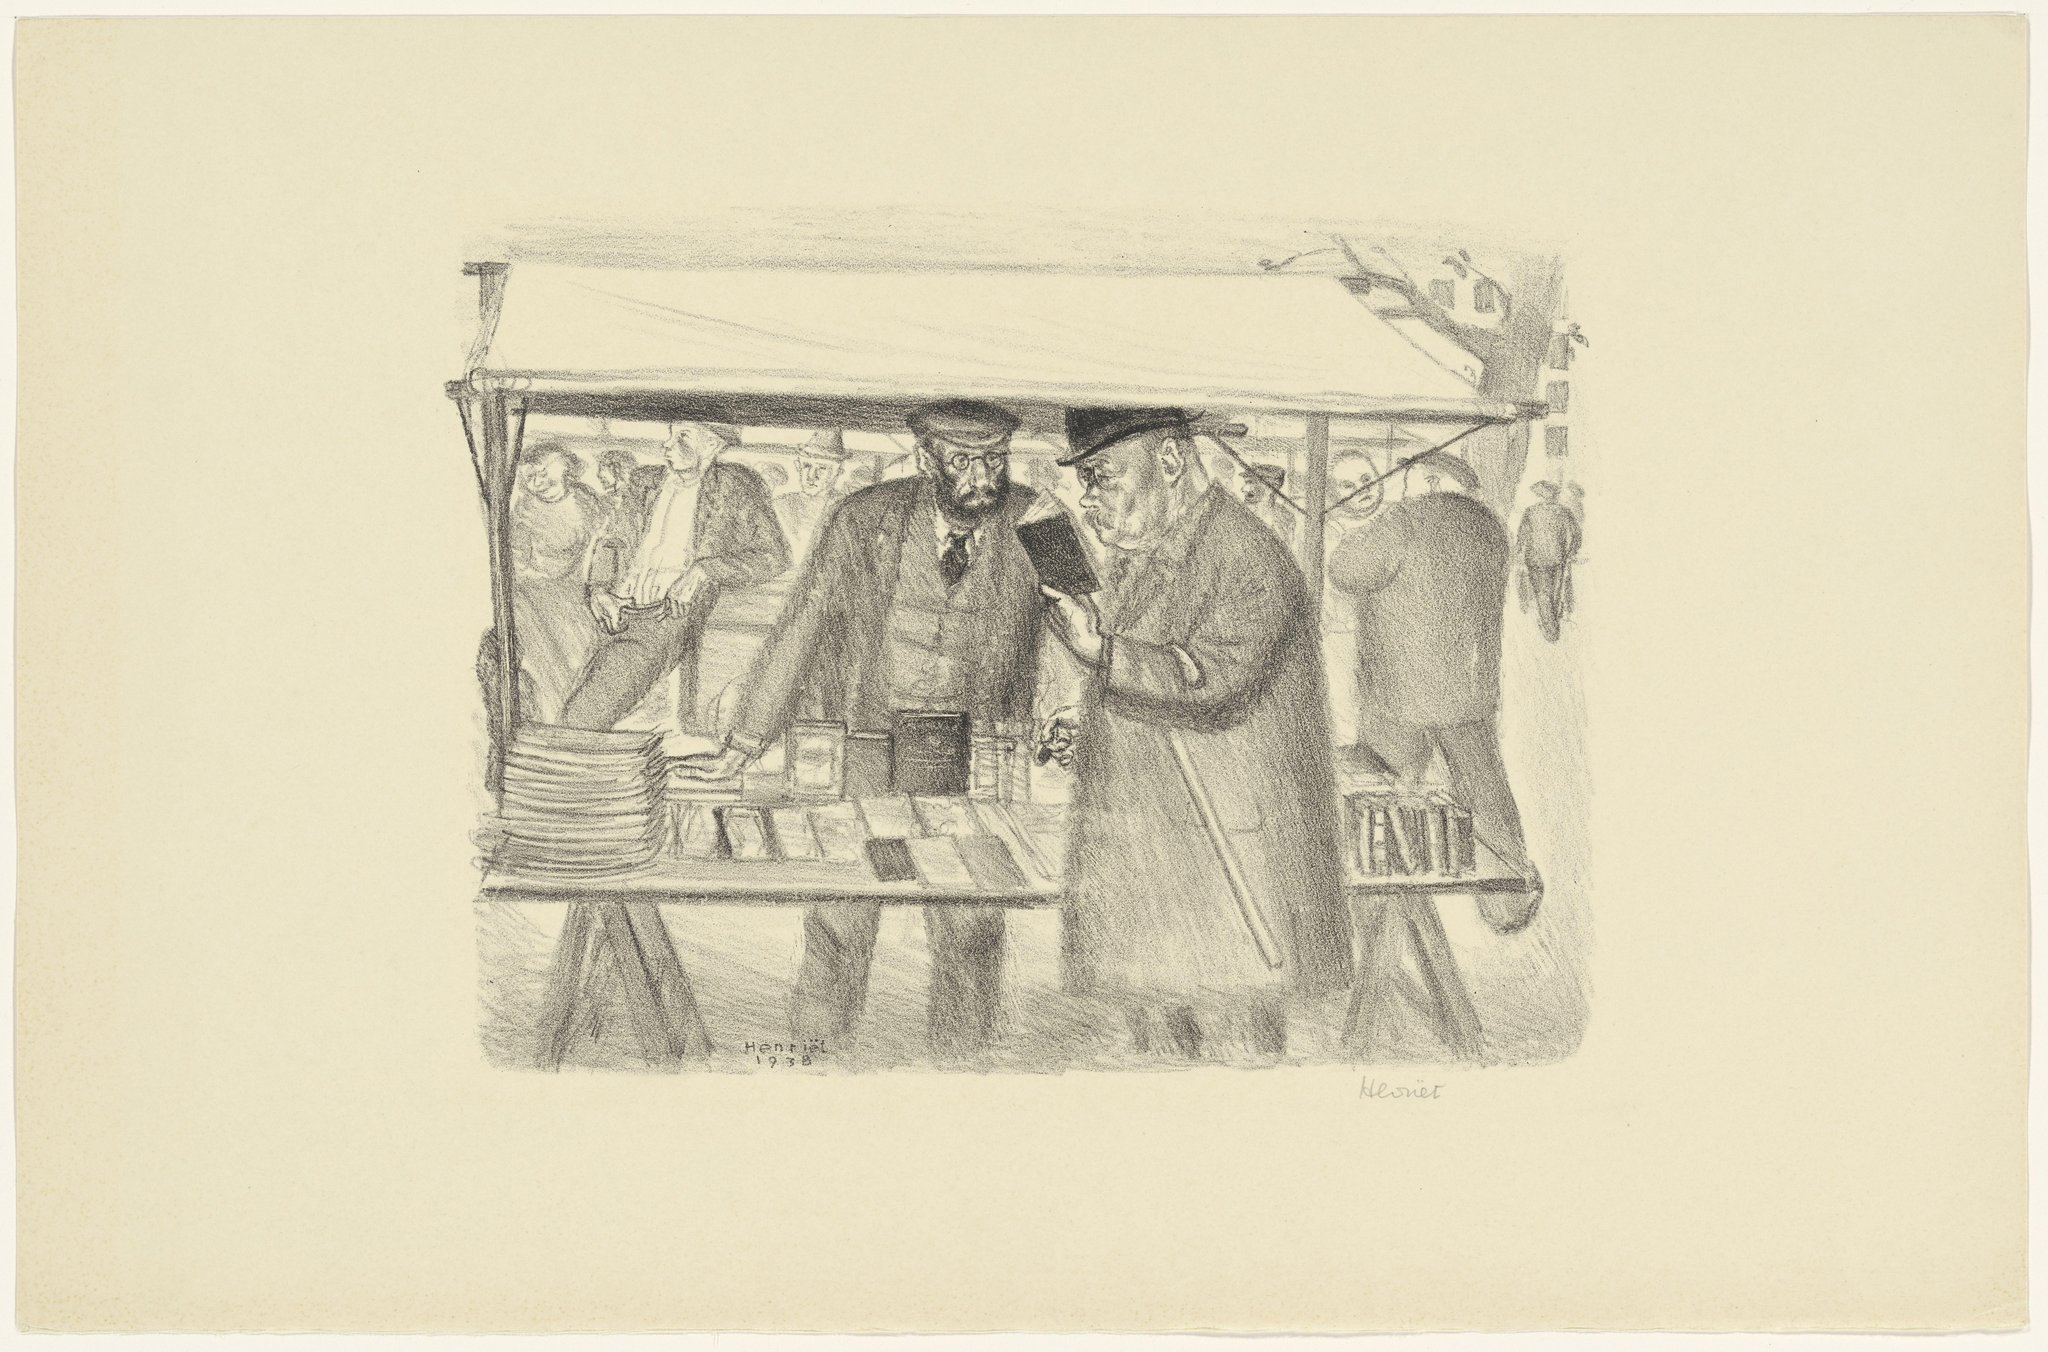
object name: print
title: Boekenstal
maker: henk henriët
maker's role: draughtsman, print maker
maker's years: 1903-1945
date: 1938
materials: paper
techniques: lithograph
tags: book-stall, kiosk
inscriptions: date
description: Een man met een bolhoed, sigaar en wandelstok staat voor de boekenstal en leest in een boek. De verkoper leunt naar voren vanachter zijn kraam.